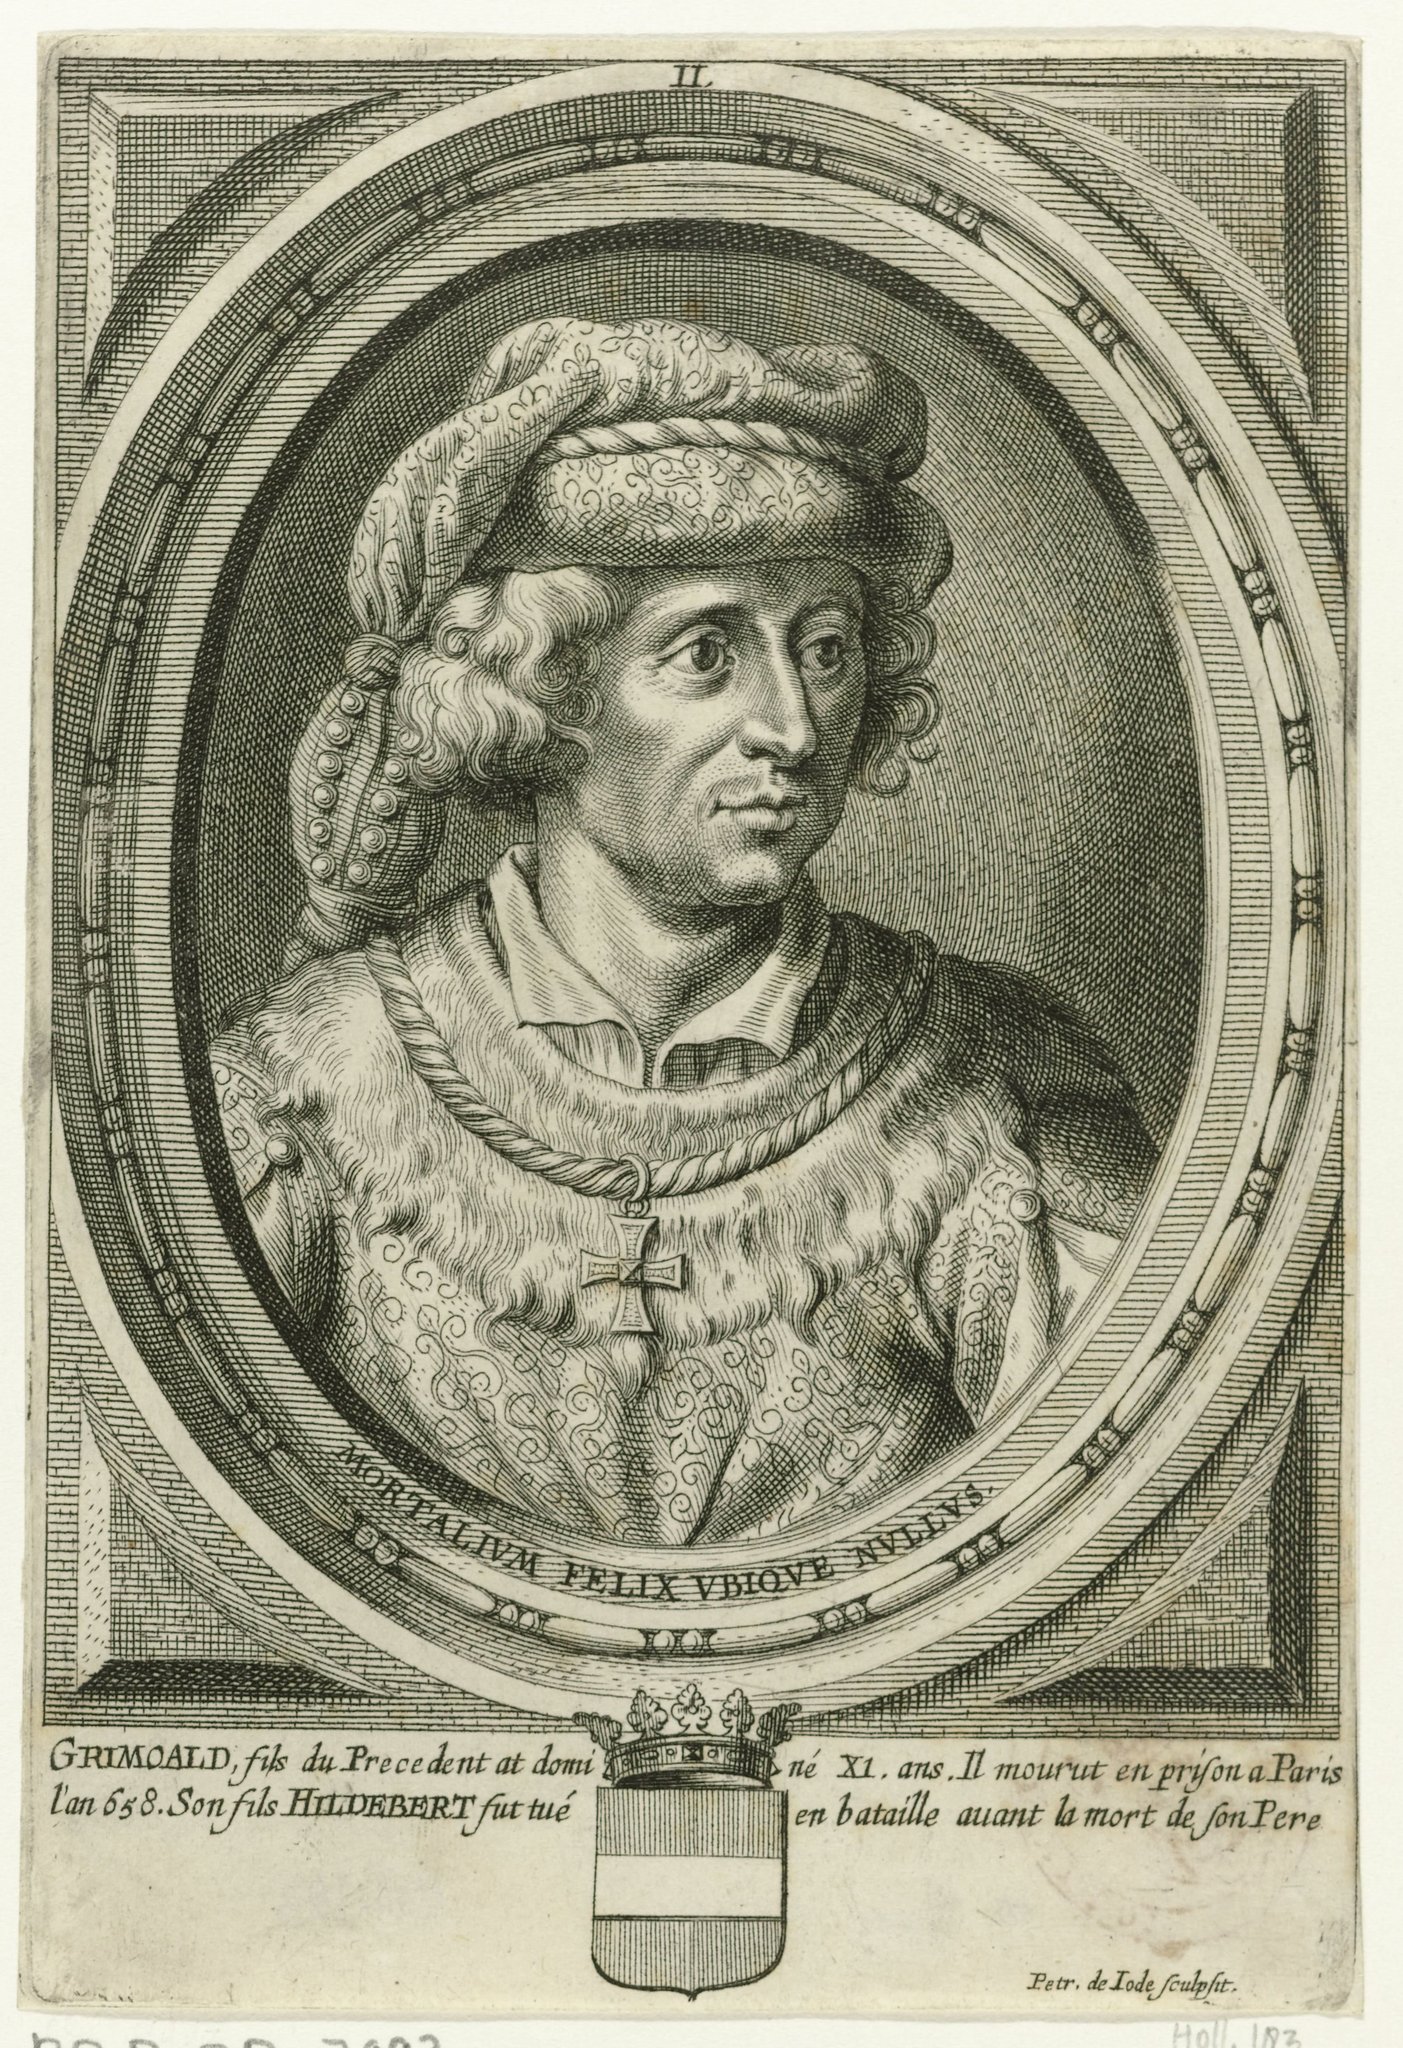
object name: book illustration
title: Portret van Grimoald (I)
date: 1661-1663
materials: paper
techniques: engraving, etching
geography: antwerp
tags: grimoald (i)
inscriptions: collector's mark: Lugt 240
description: Busteportret van Grimoald (I), met muts. Het portret is gevat in een ovale omlijsting met een motto in het Latijn. In de marge het wapenschild van de geportretteerde en een tweeregelig onderschrift in het Frans. Prent uit een boek waarin 54 prenten met portretten.